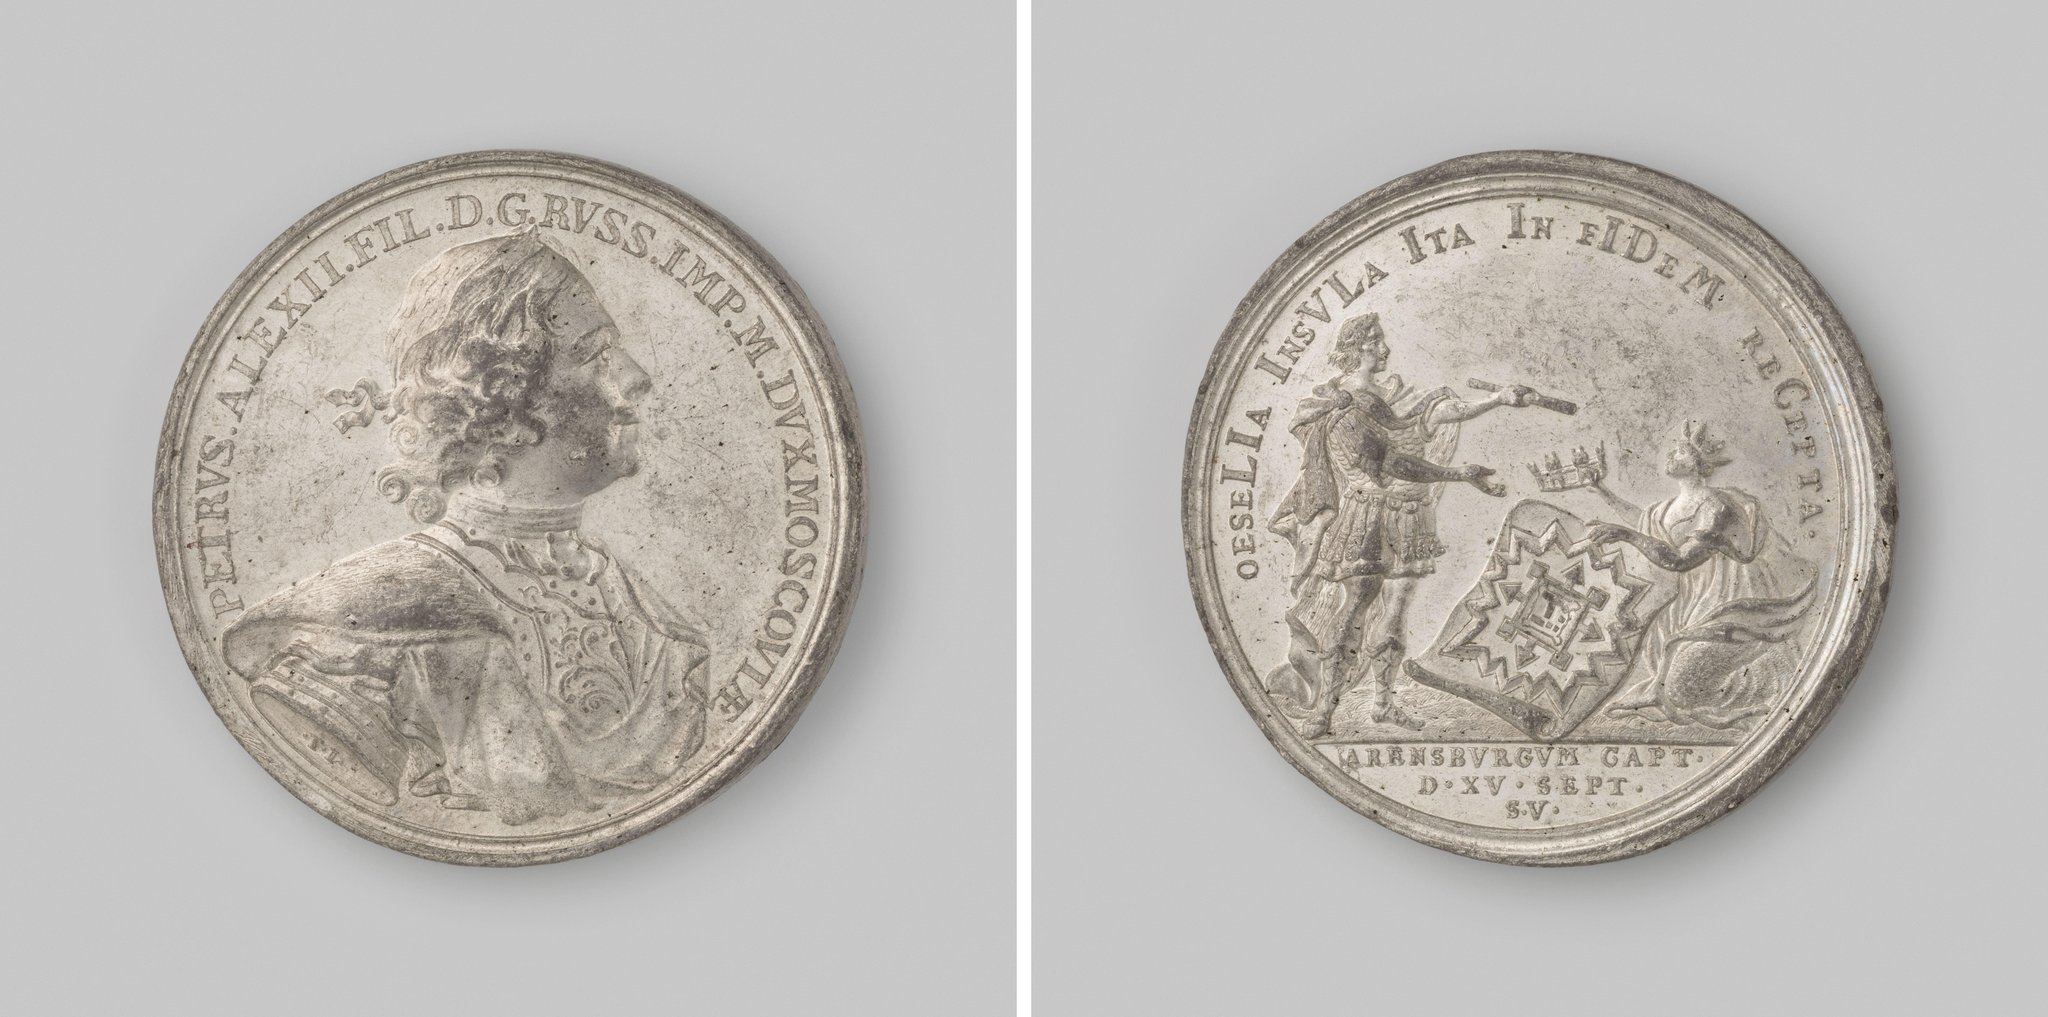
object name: history medal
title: Inname van Arensburg door Rusland op Zweden 1710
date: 1710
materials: tin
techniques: striking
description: Tinnen penning, op de voorzijde het borstbeeld van Tsaar Peter de Grote naar rechts met omschrift, op de keerzijde Tsaar Peter die een muurkroon aanneemt van de stadsgodin, een plattegrond van Arensburg in de hand, met omschrift en afsnedetekst.